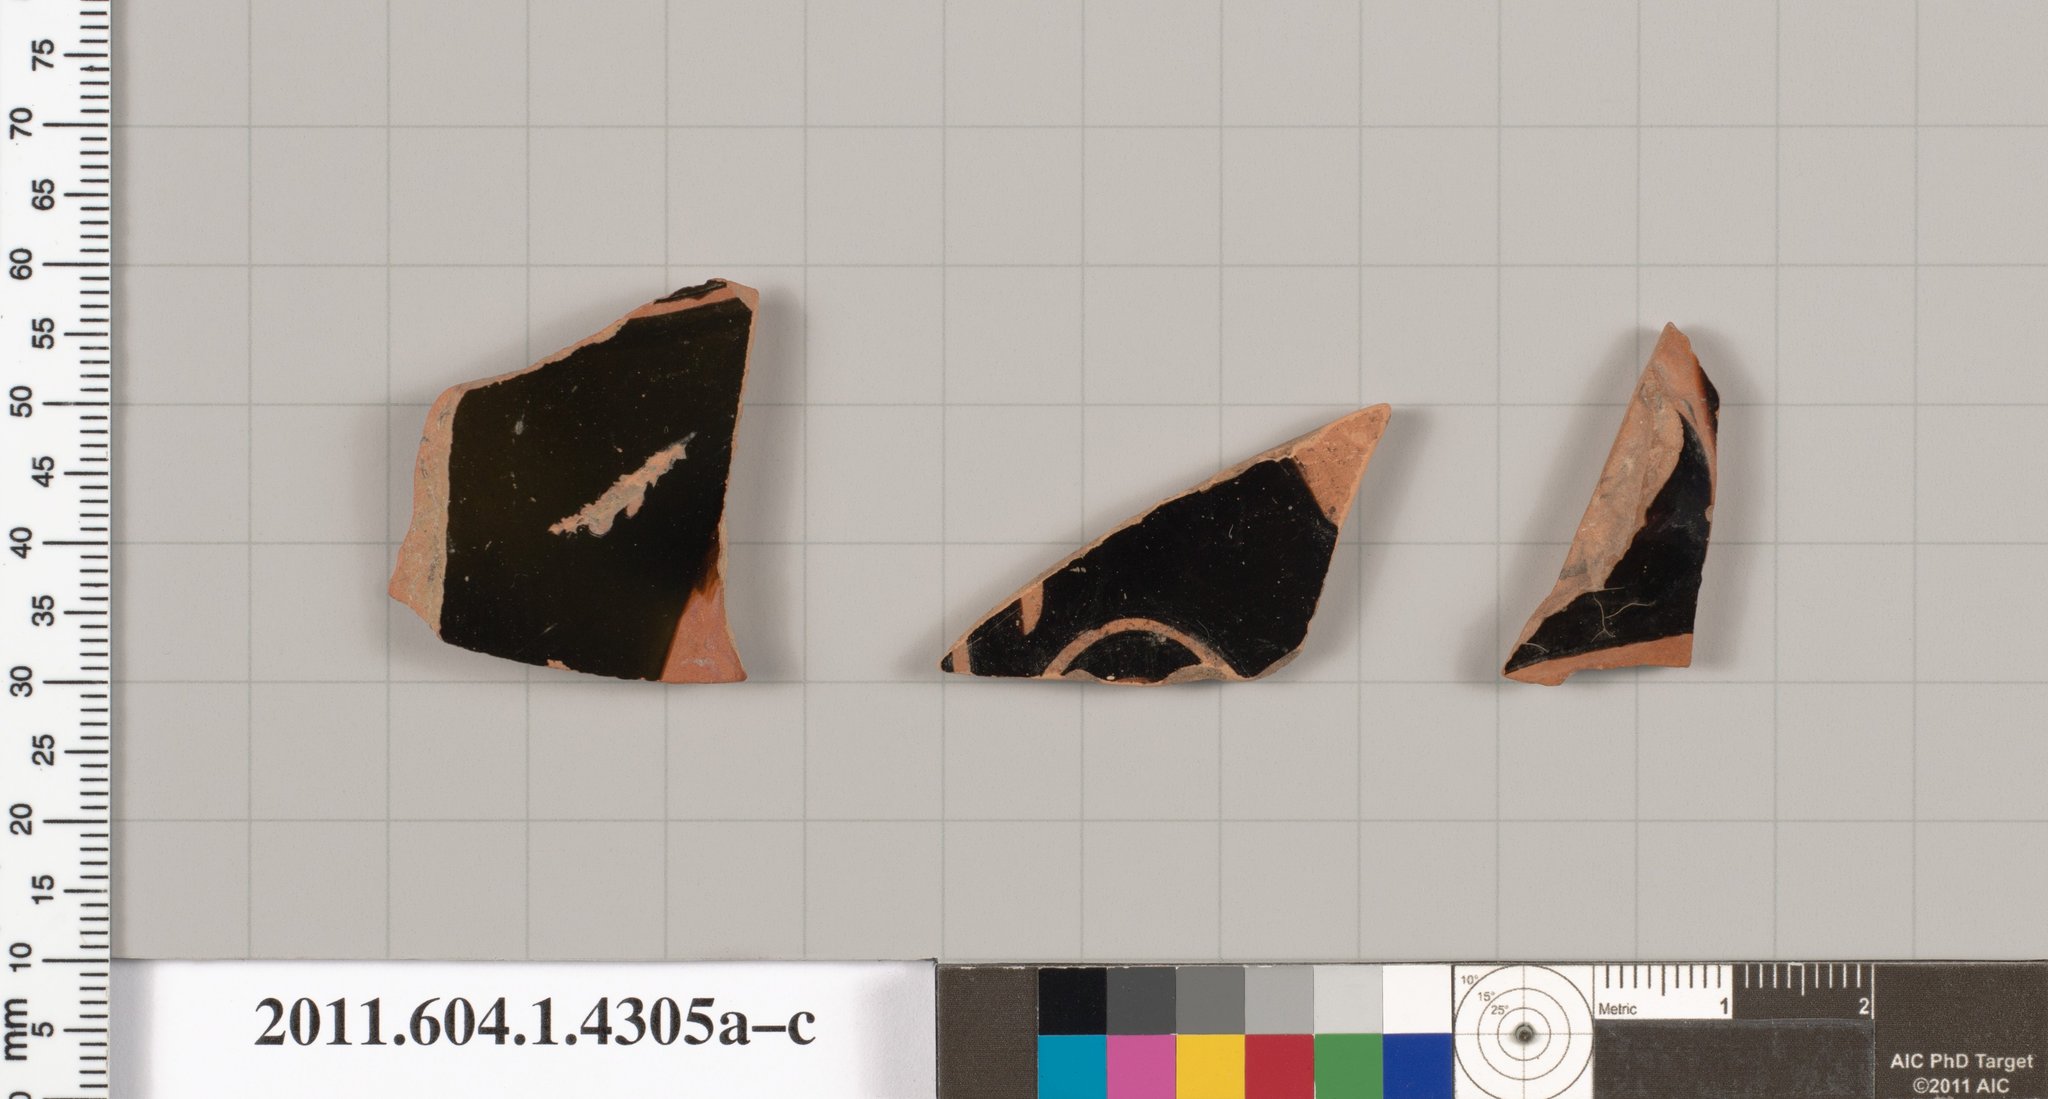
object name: kylix fragment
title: Terracotta fragments of kylikes (drinking cups)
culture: greek, attic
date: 500-451 BCE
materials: terracotta